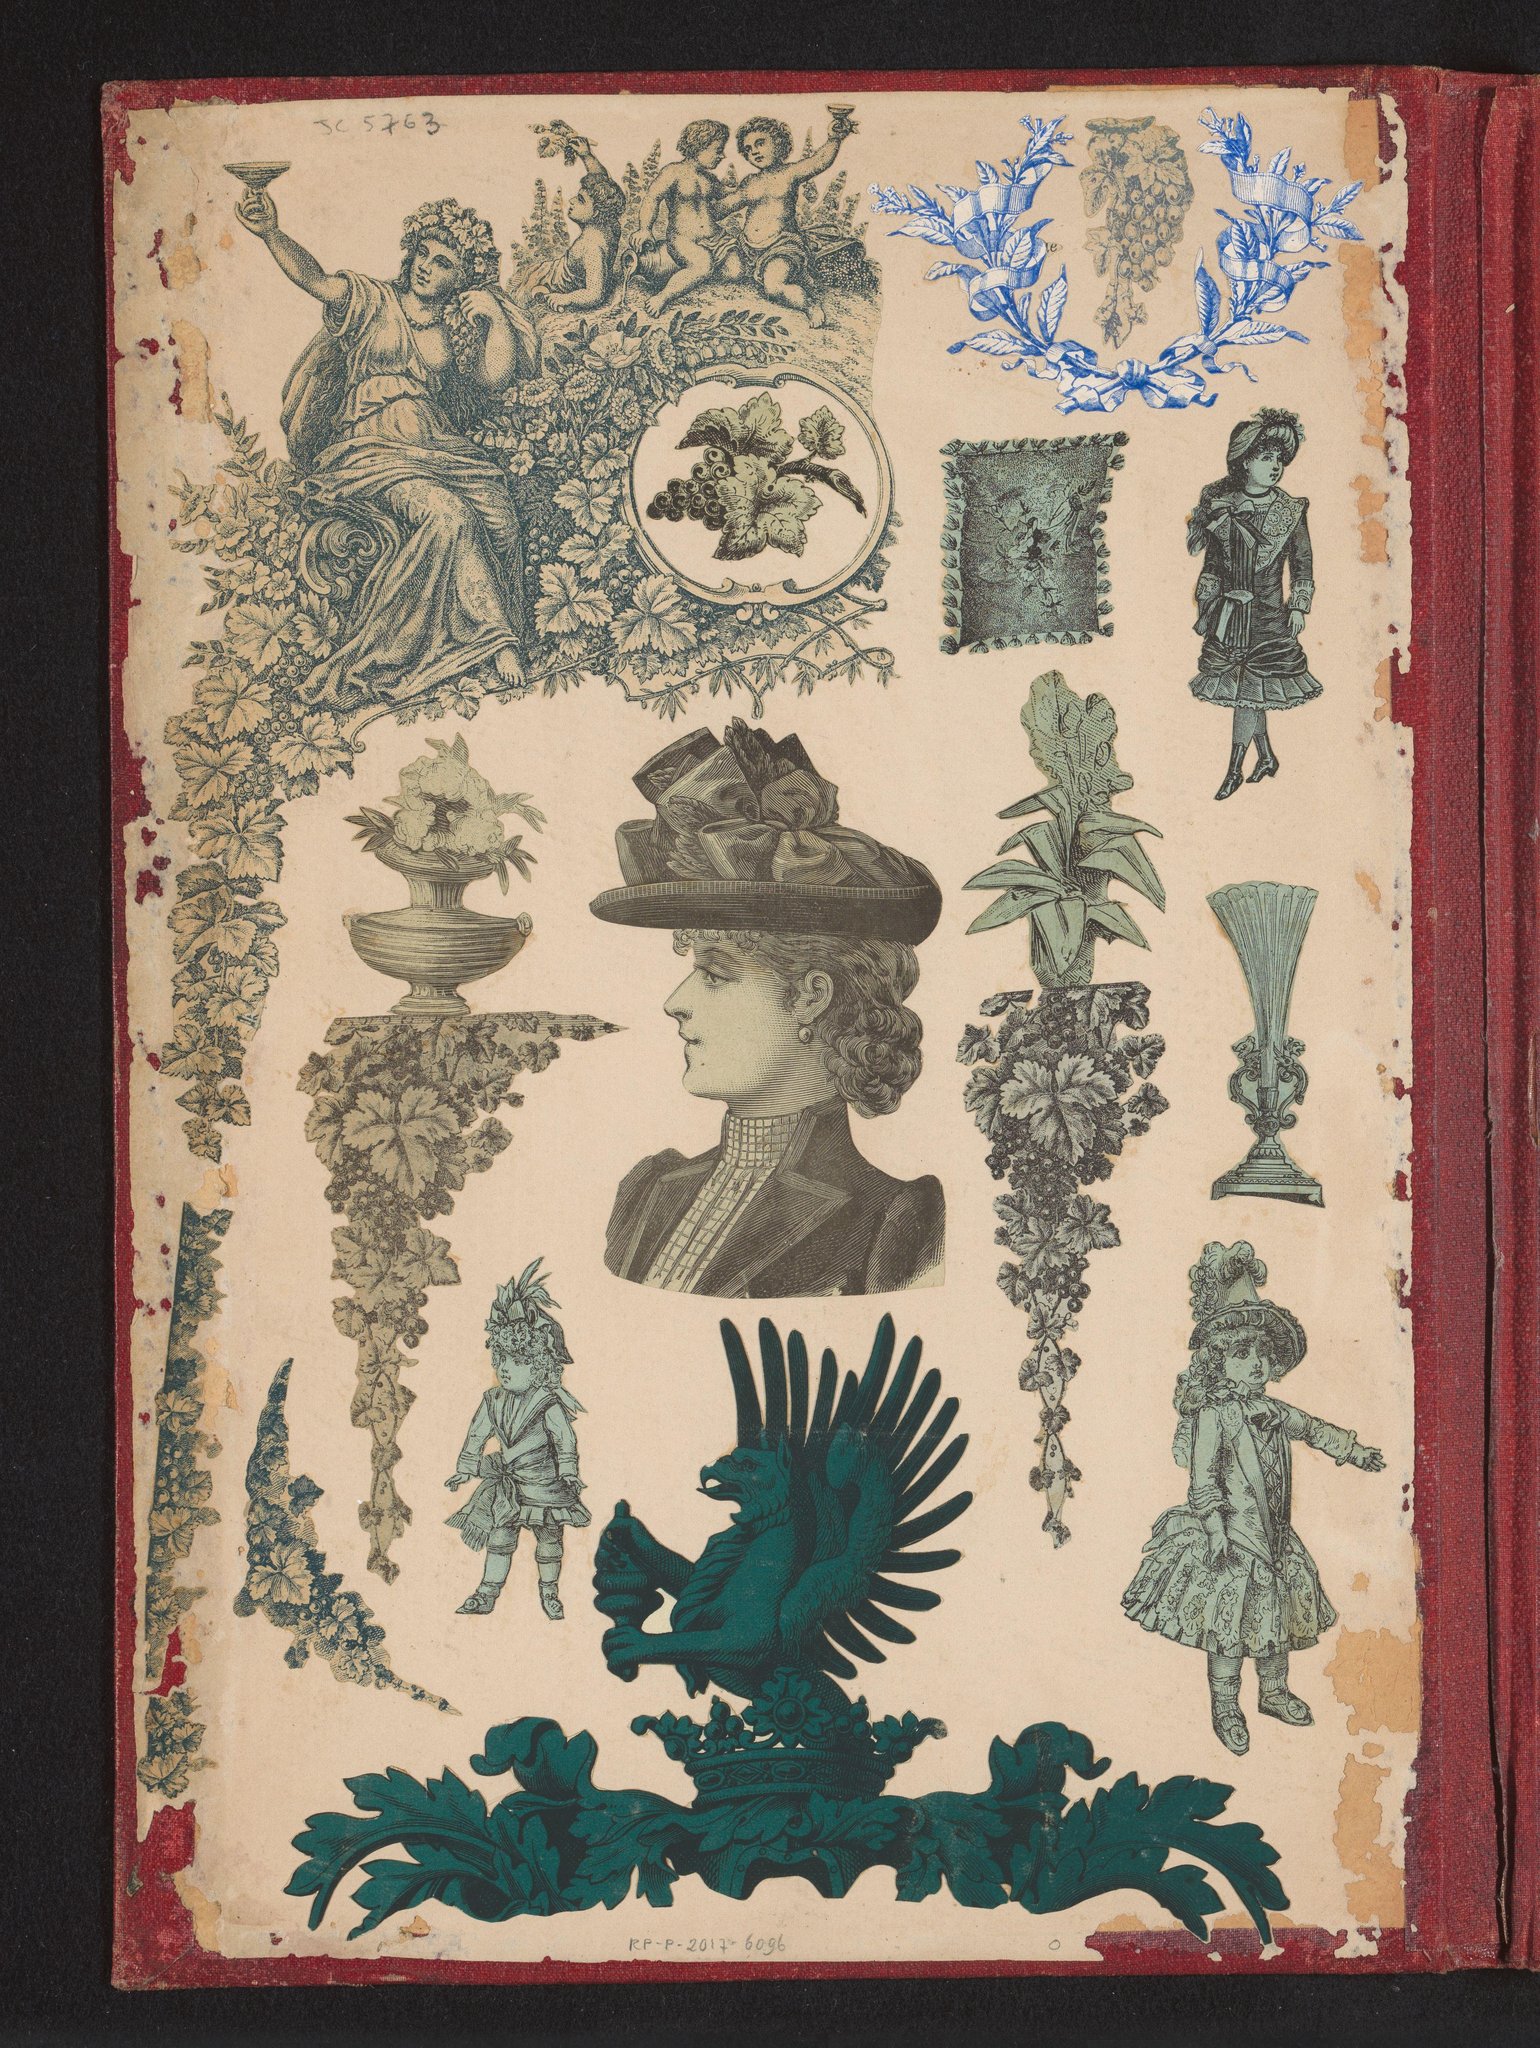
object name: endleaf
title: Collage van uitgeknipte prenten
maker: Anonymous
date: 1870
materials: paper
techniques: engraving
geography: paris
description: Collage van uitgeknipte prenten geplakt op het voorste schutblad. Onderdeel van een album met 18 bladen, aan beide zijden beplakt met uitgeknipte prenten, vermoedelijk afkomstig uit 19e-eeuwse tijdschiften.